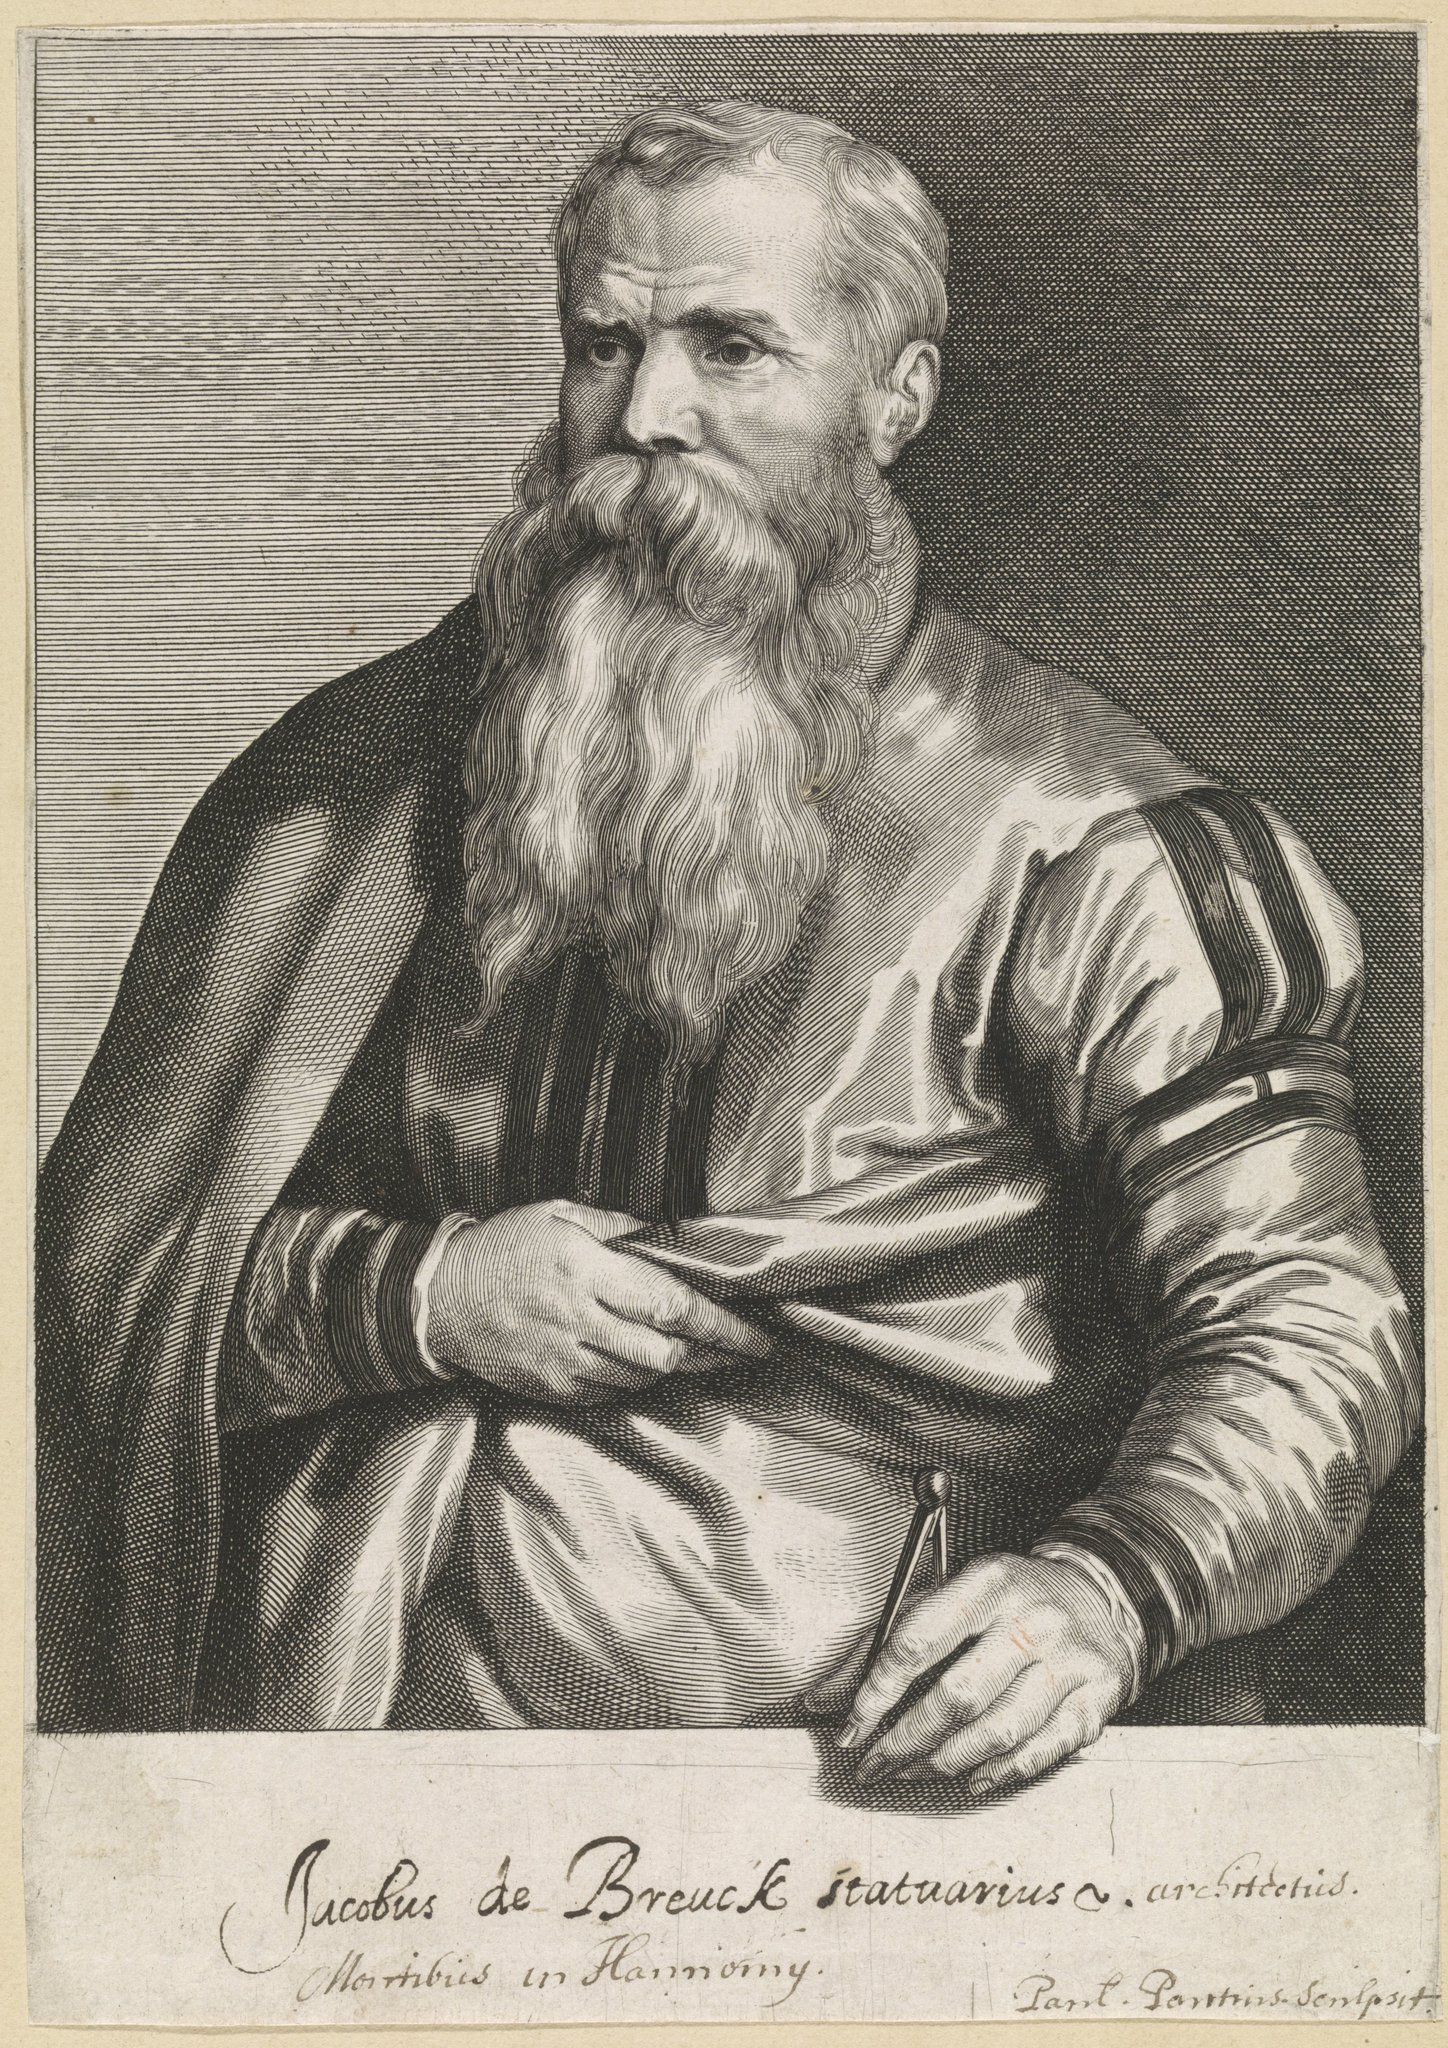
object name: print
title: Portret van Jacob de Breuck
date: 1616-1657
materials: paper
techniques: engraving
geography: antwerp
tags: sculptor, compasses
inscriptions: inscription: ‘Jacobus de Breuck [...] Pontius sculpsit’, collector's mark: Lugt 240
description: Portret van de architect en beeldhouwer Jacob de Breuck. In zijn linkerhand houdt hij een passer.